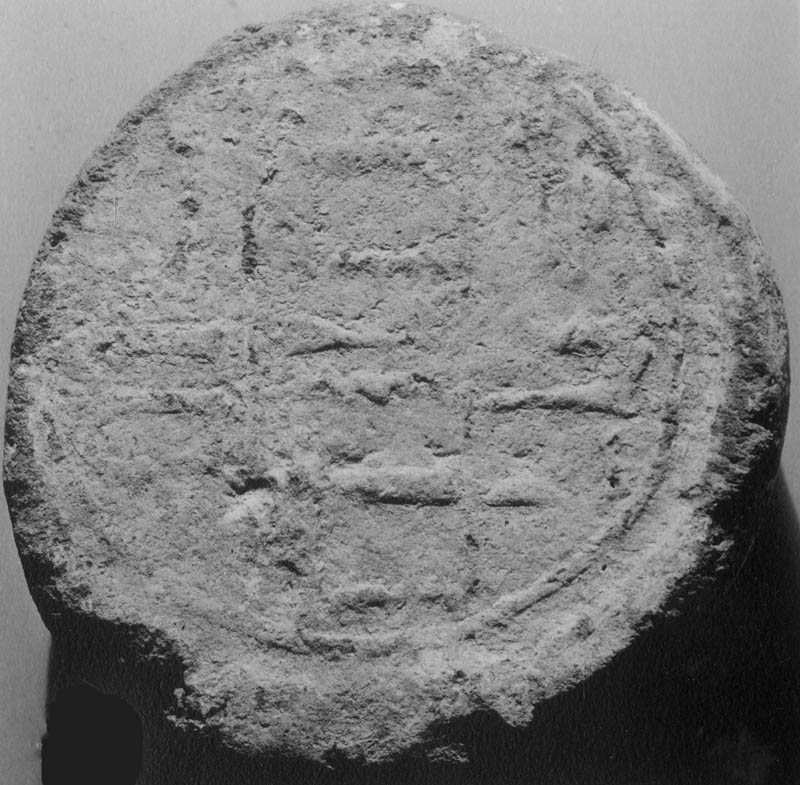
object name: cone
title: Funerary Cone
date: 1550-1295 BCE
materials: pottery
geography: egypt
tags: hieroglyphs